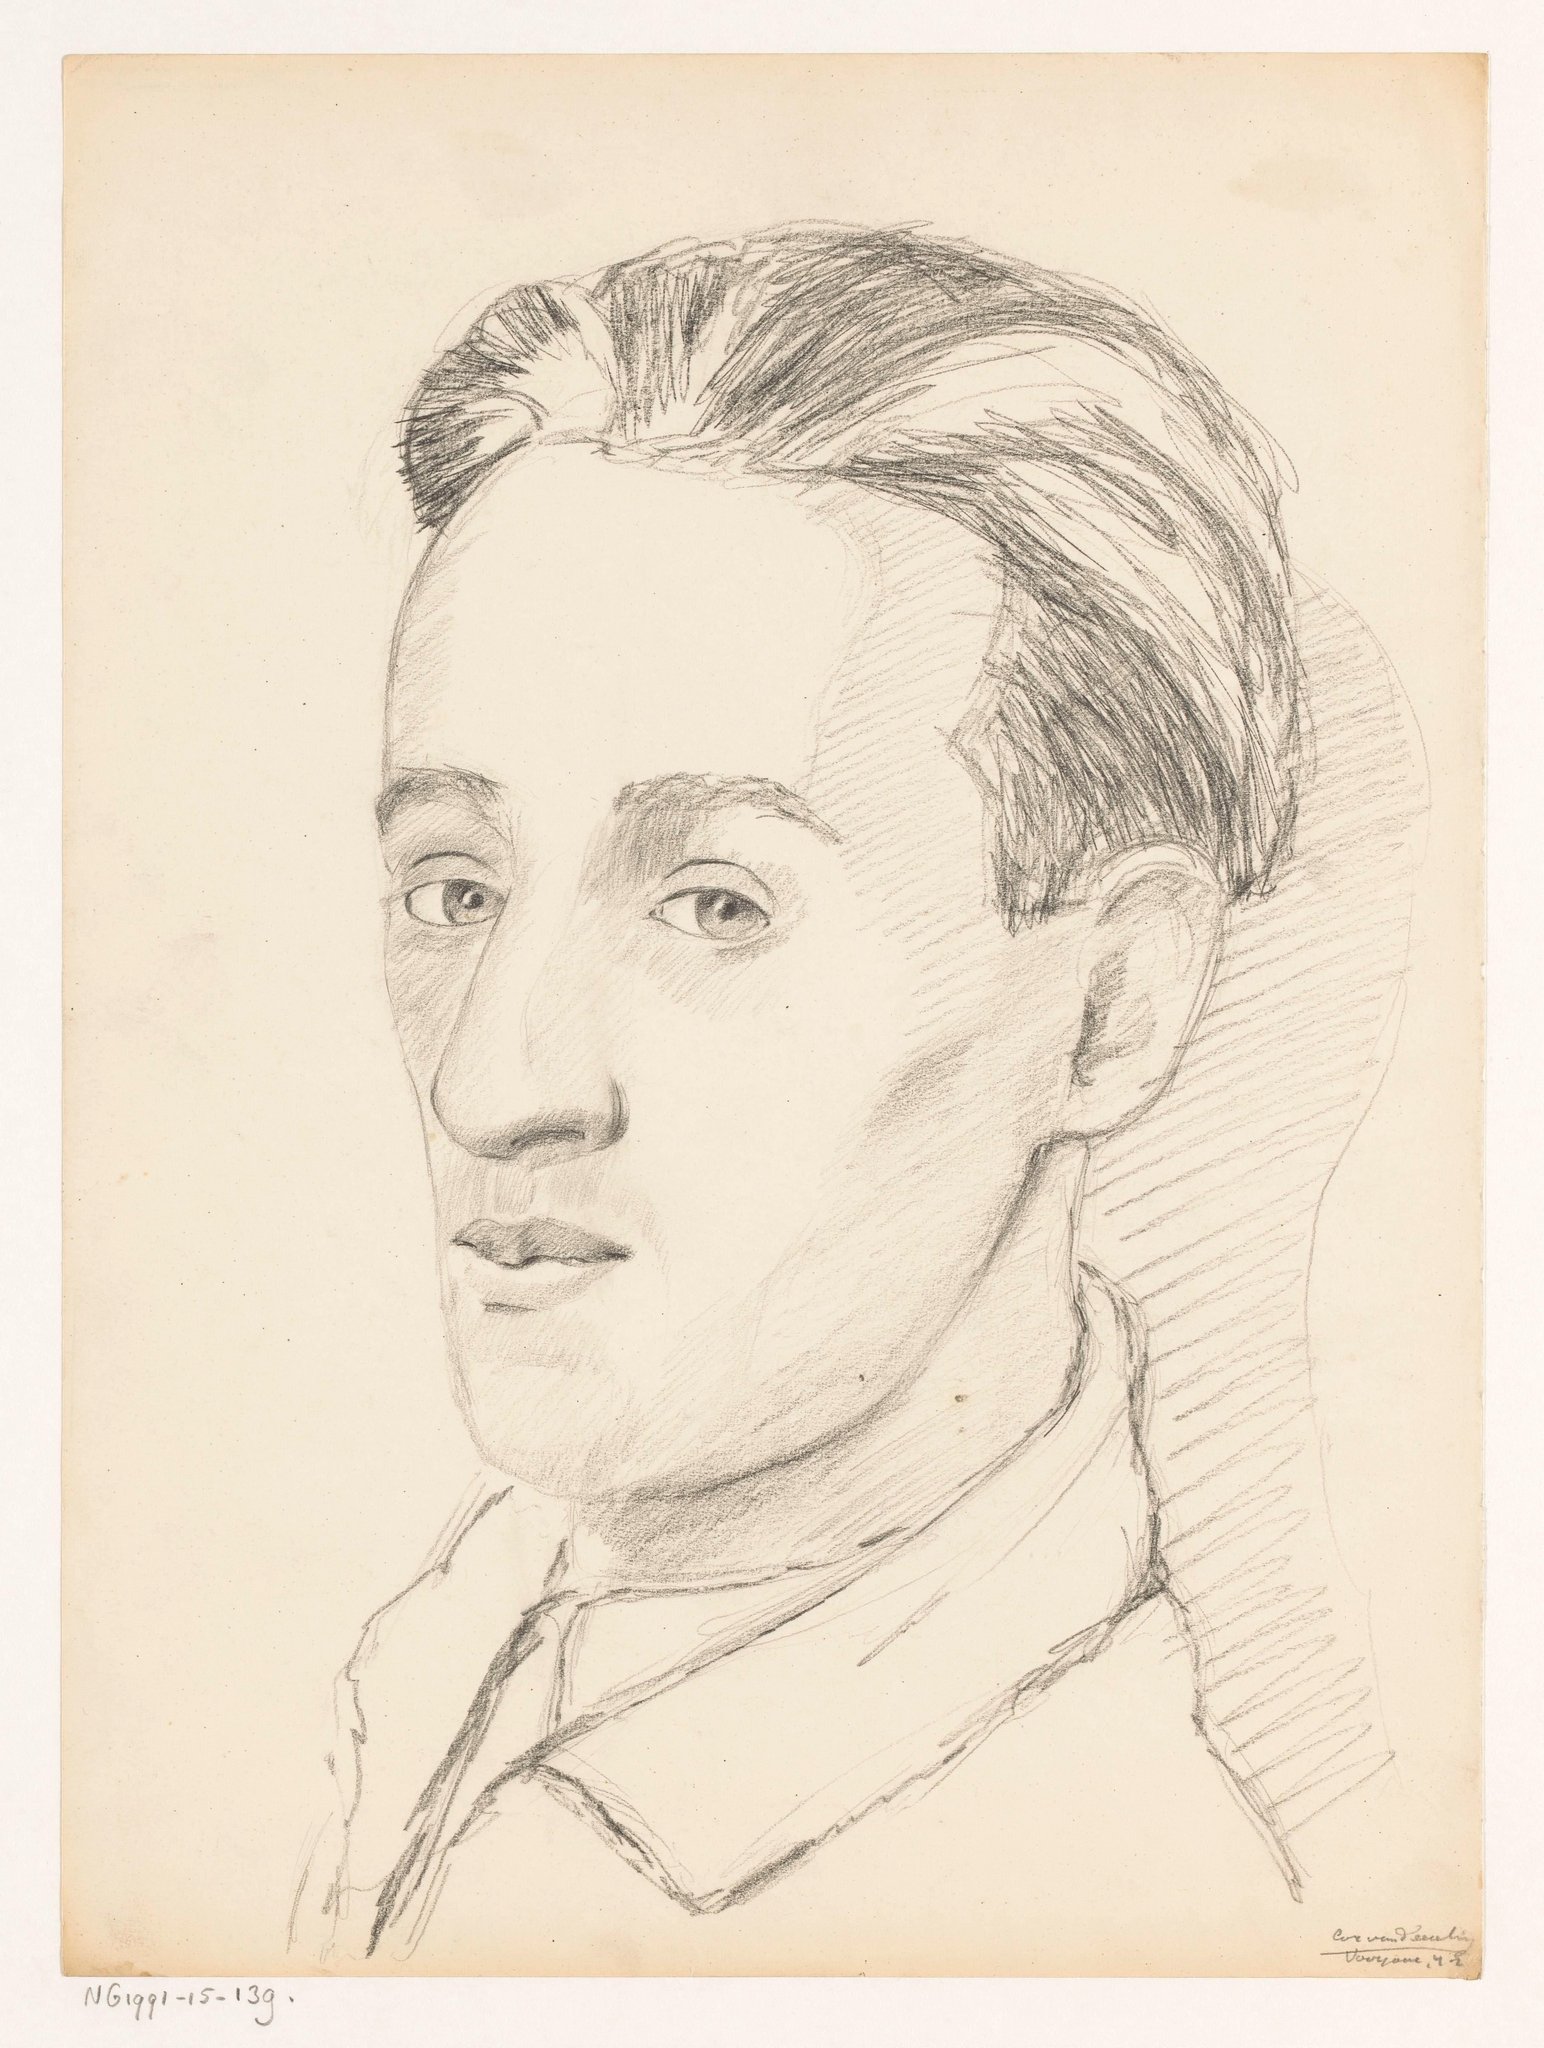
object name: drawing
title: Zelfportretten van Cor van Teeseling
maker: cor van teeseling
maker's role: draughtsman, sculptor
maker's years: 1915-1942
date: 1942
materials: paper, chalk, pencil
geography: amsterdam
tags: amsterdam, draughtsman, sculptor, cor van teeseling, historical persons, prisoner in cell or locked place, portrait, self-portrait of draughtsman, netherlands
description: Zelfportret van Cor van Teeseling, voorjaar 1942. Cor van Teeseling driekwart afgebeeld, zijn hoofd naar links gewend.